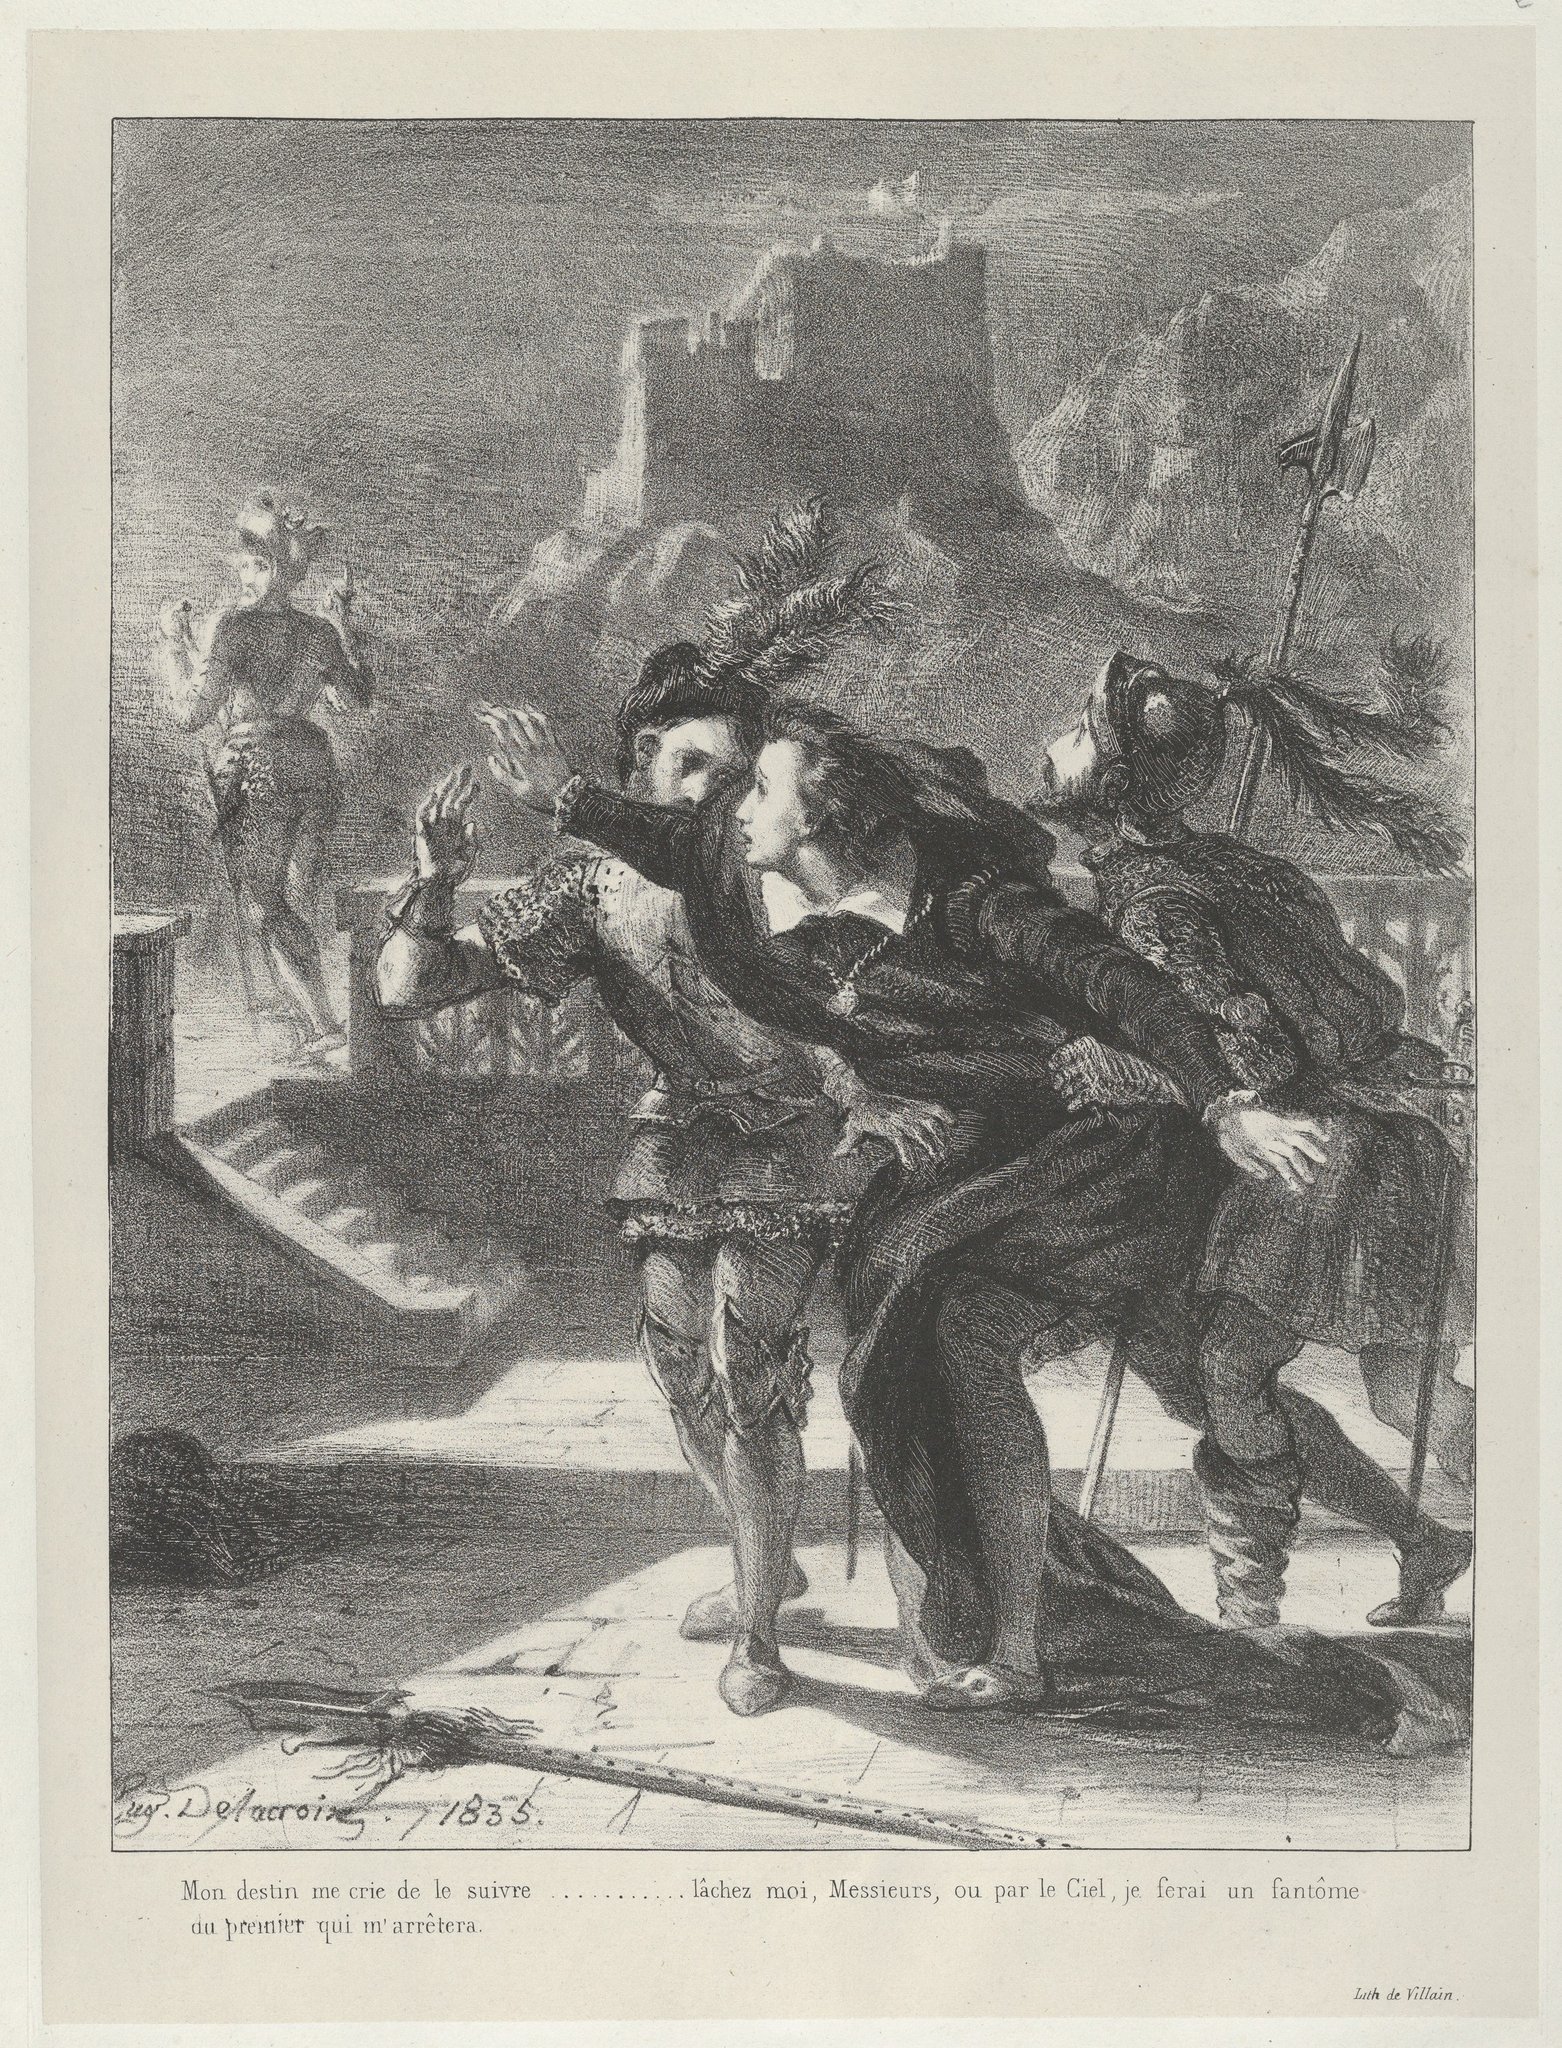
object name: print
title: Hamlet Tries To Follow His Father's Ghost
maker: eugène delacroix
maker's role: artist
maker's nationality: french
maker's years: 1798-1863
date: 1835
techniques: lithograph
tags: shakespeare,men,hamlet